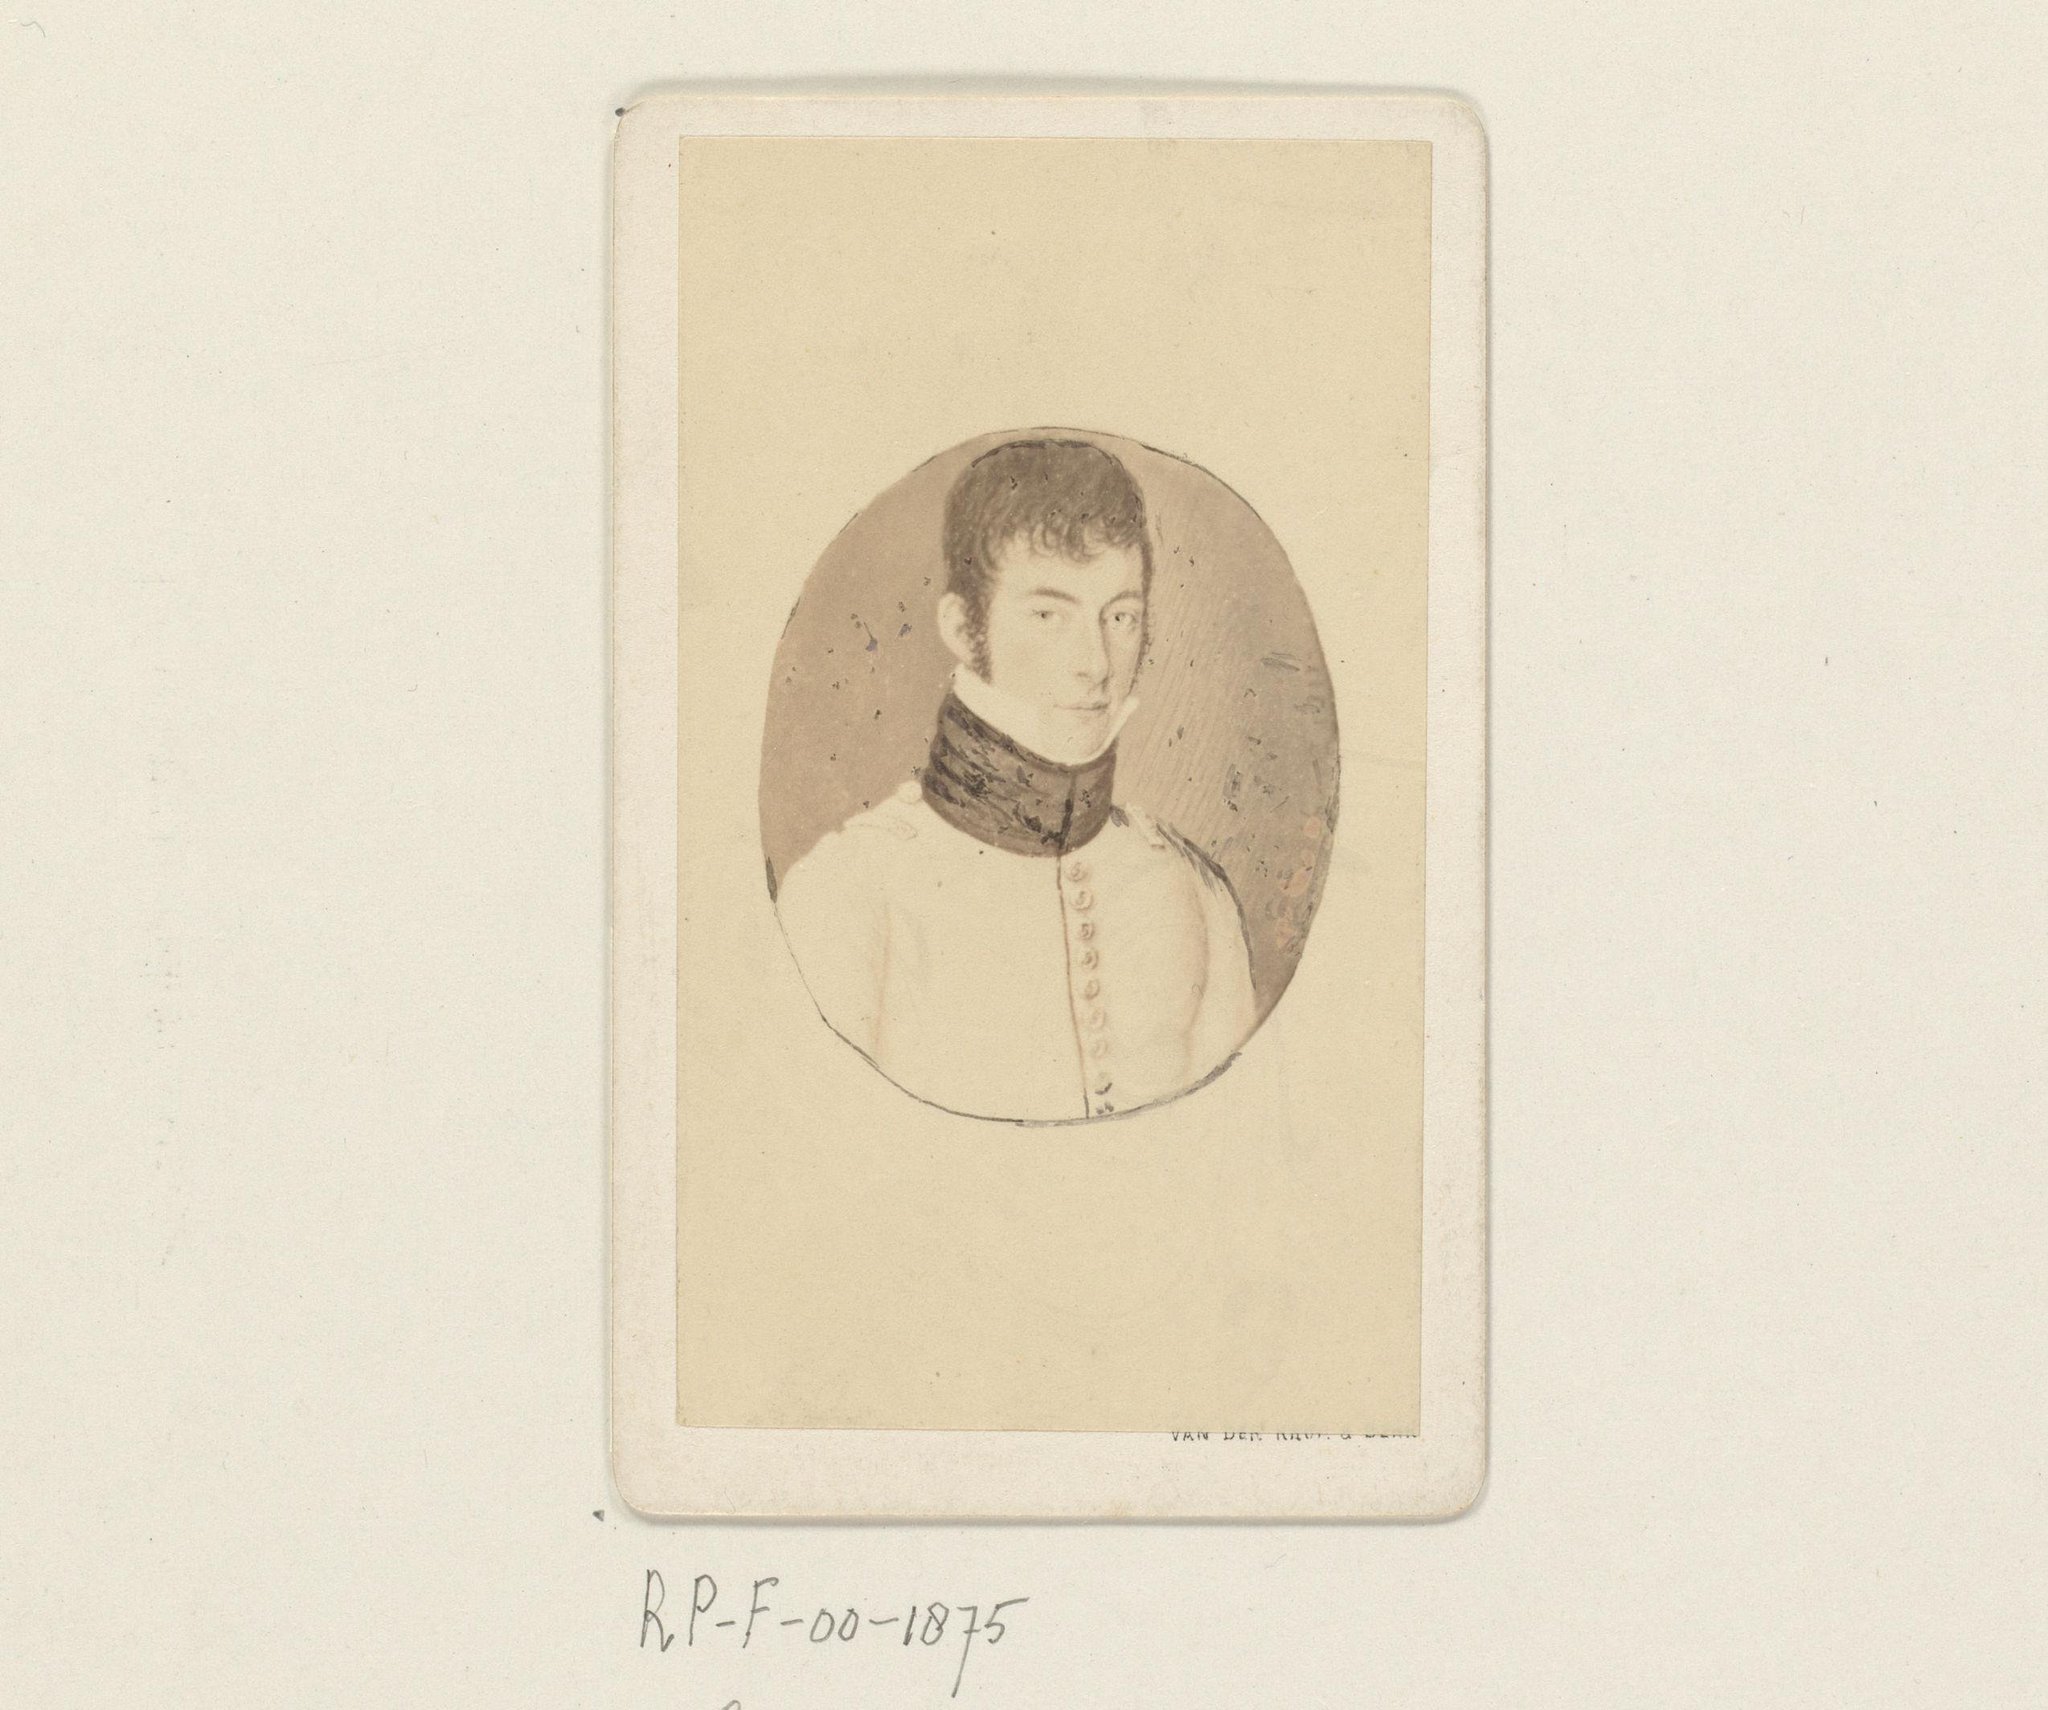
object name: reproduction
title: Fotoreproductie van een getekend portret van een onbekende man, mogelijk Willem Bilderdijk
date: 1865-1871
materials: cardboard, paper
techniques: albumen print, retouching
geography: the hague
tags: amsterdam, print maker, willem bilderdijk, drawing, sketch, historical persons not known by name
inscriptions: inscription: ‘Bilderdijk?’, inscription: ‘Firma Buckmann (...) 's Hage’